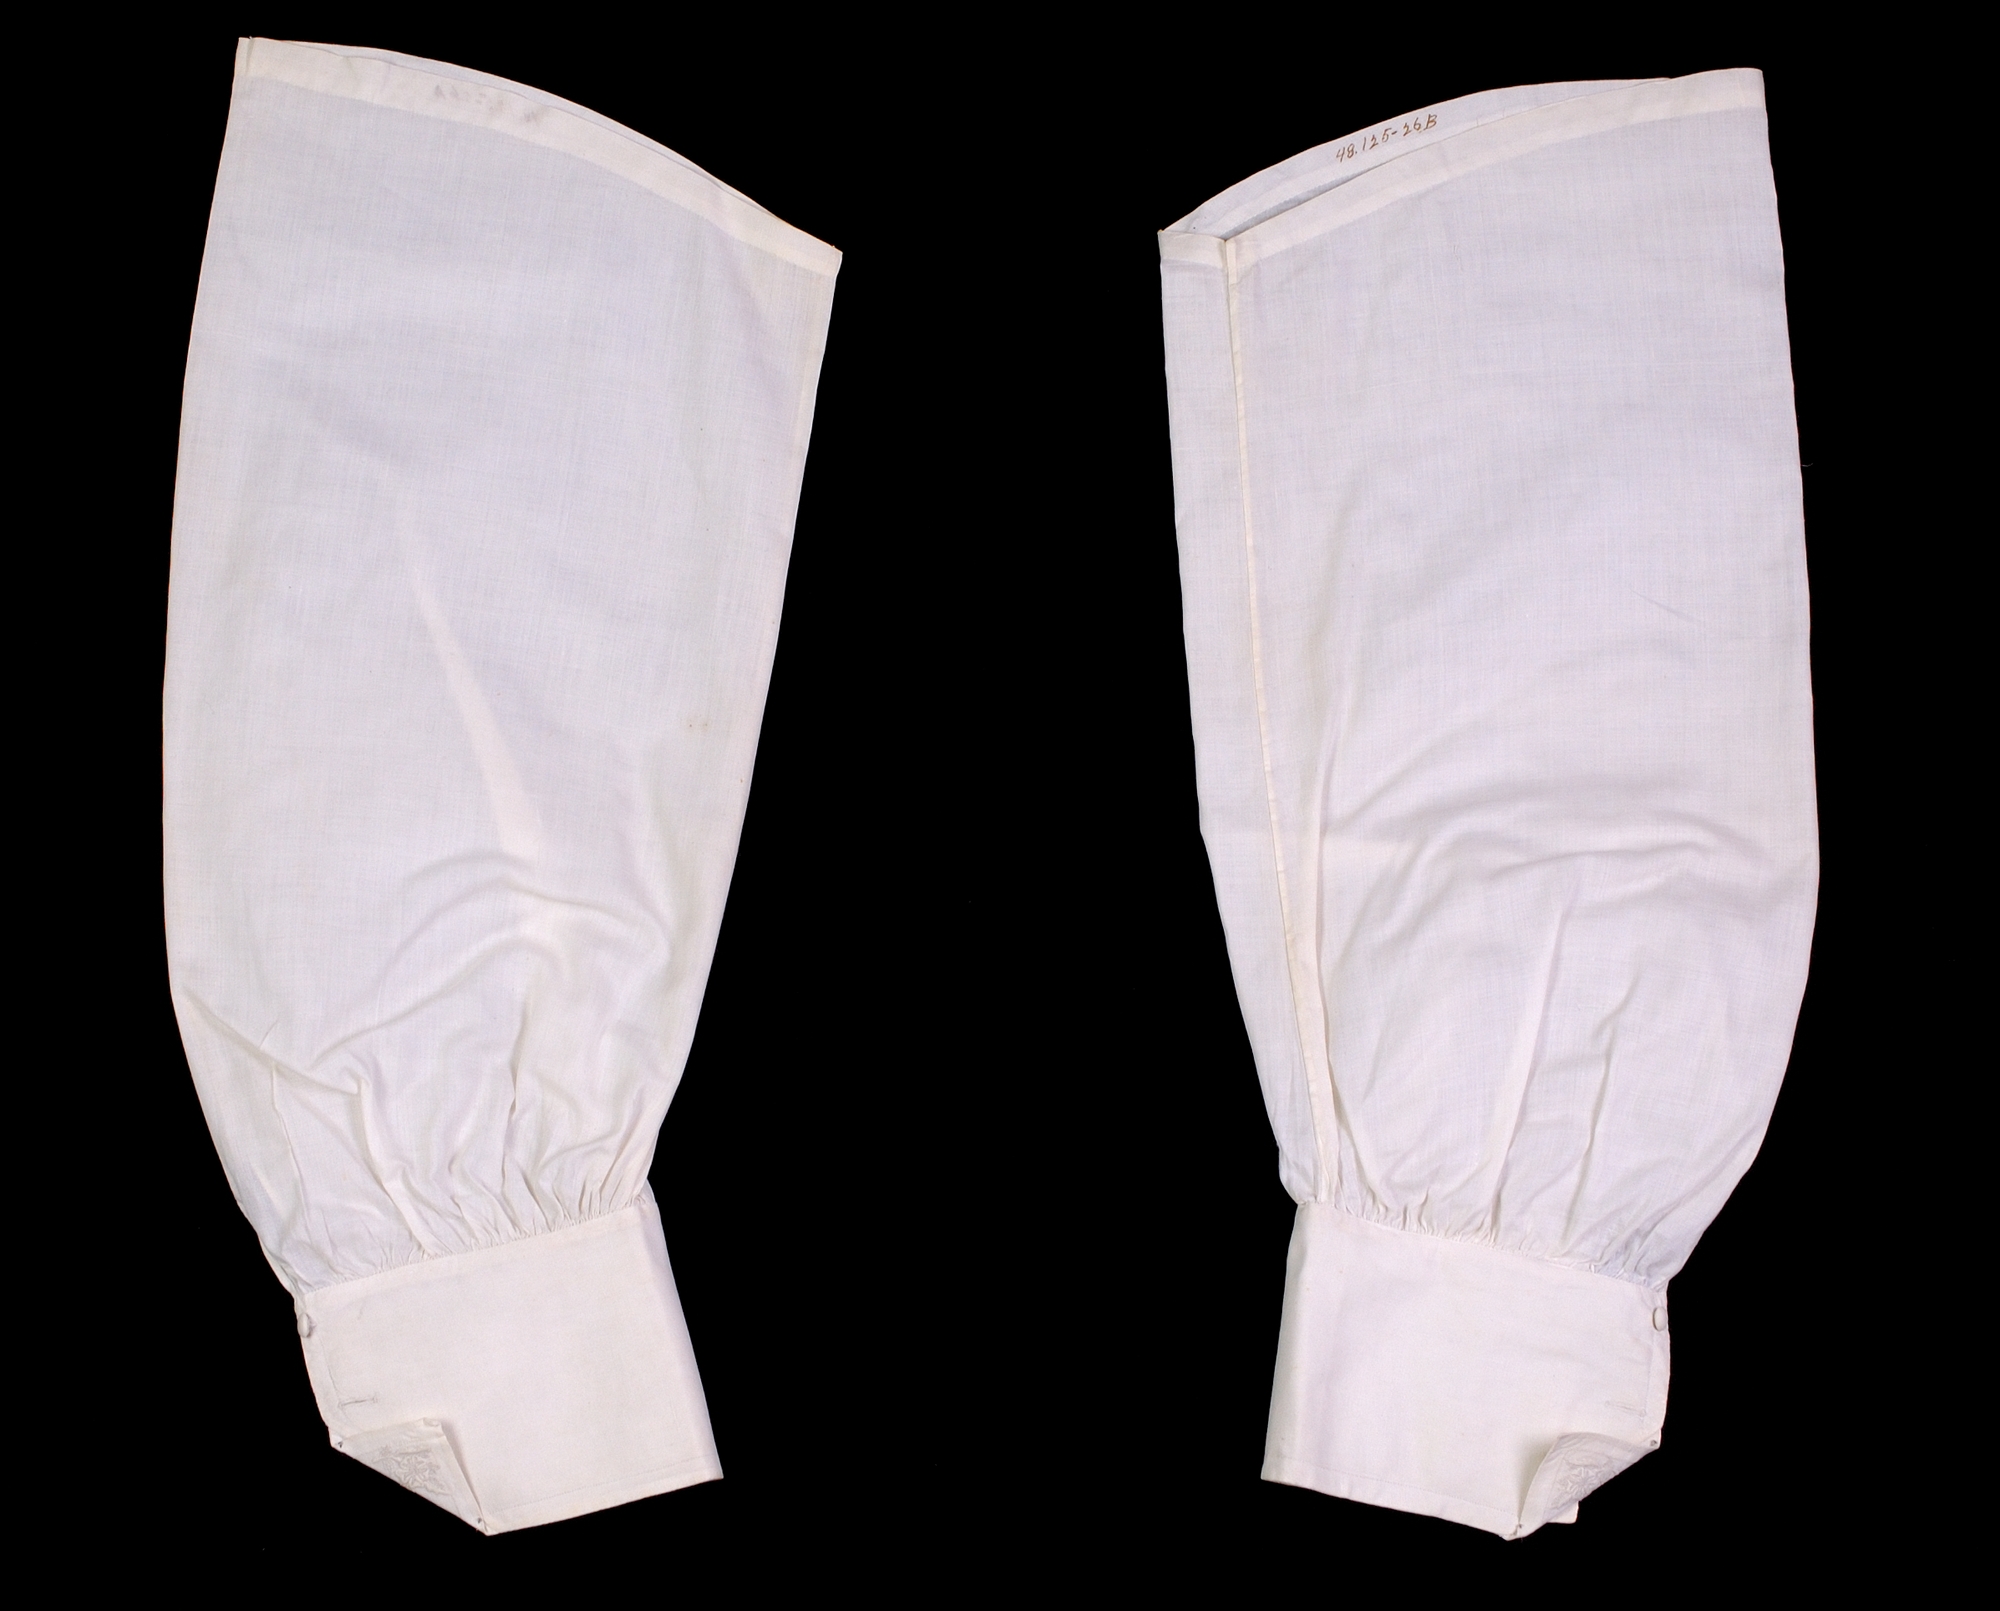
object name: undersleeves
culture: american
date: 1870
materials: linen